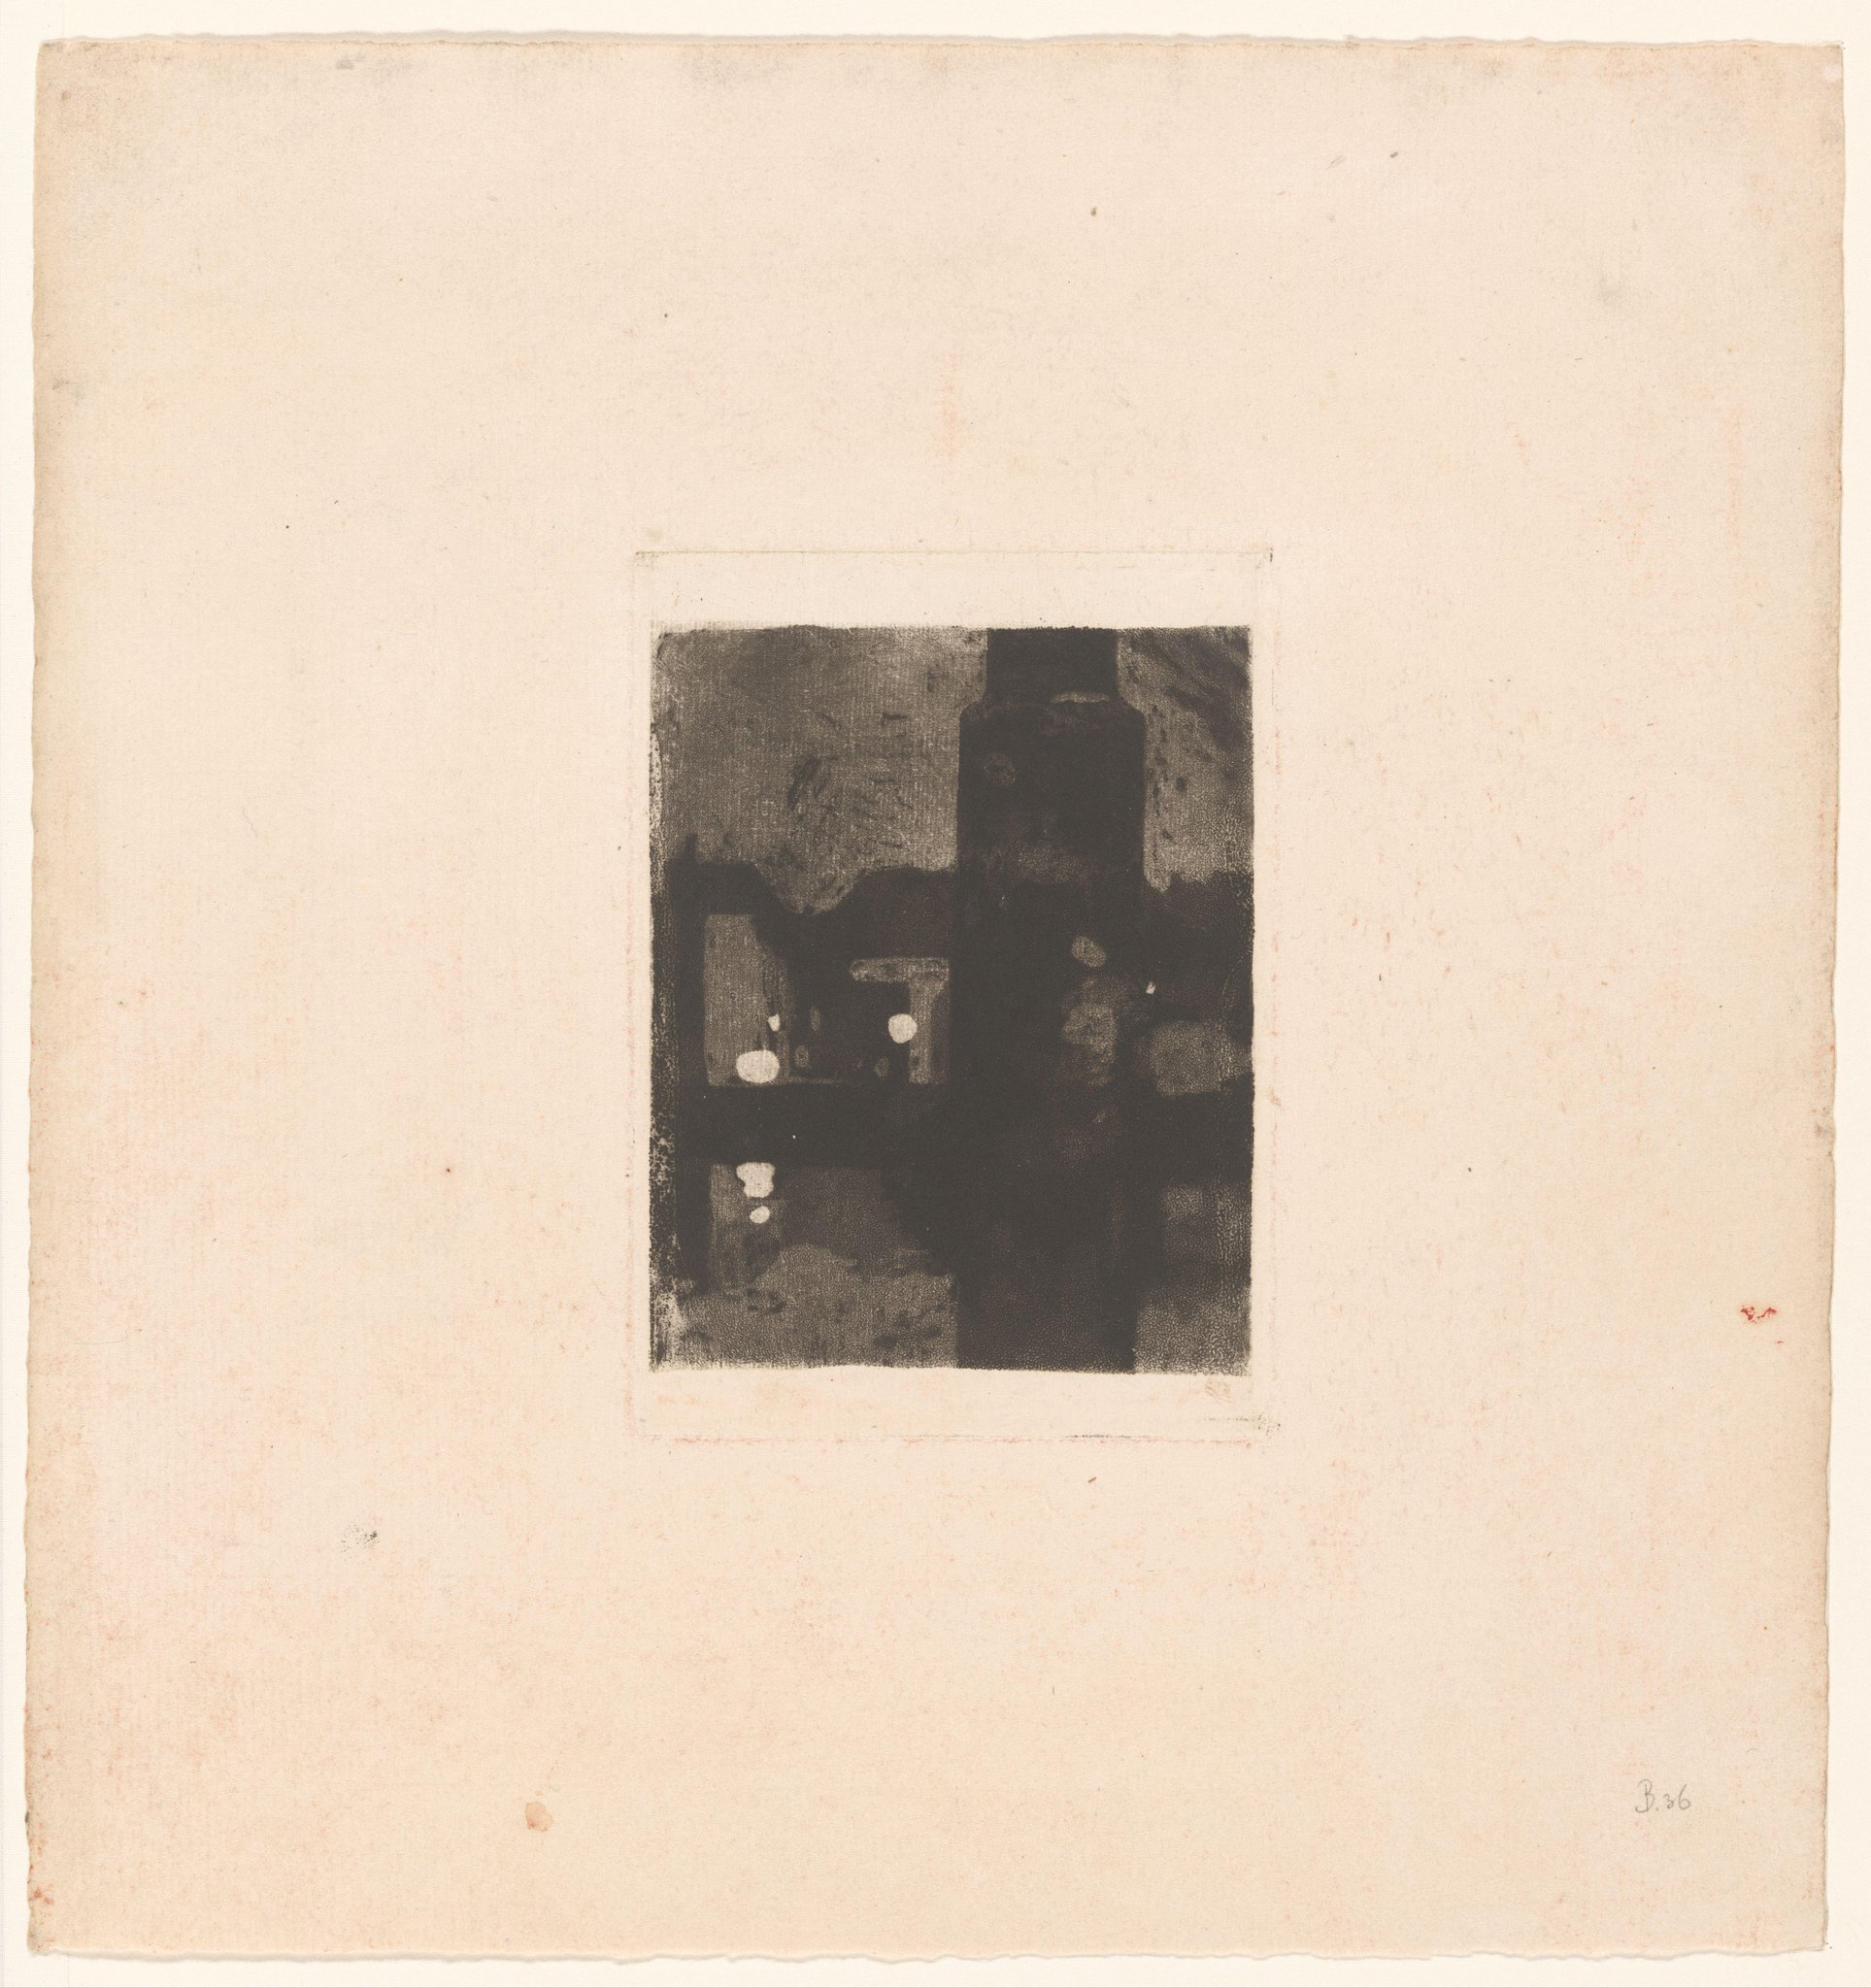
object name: print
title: Montelbaanstoren bij avond in Amsterdam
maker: willem witsen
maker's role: draughtsman, painter, print maker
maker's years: 1860-1923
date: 1887-1888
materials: paper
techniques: aquatint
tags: tower, clock tower ~ monumental adornment